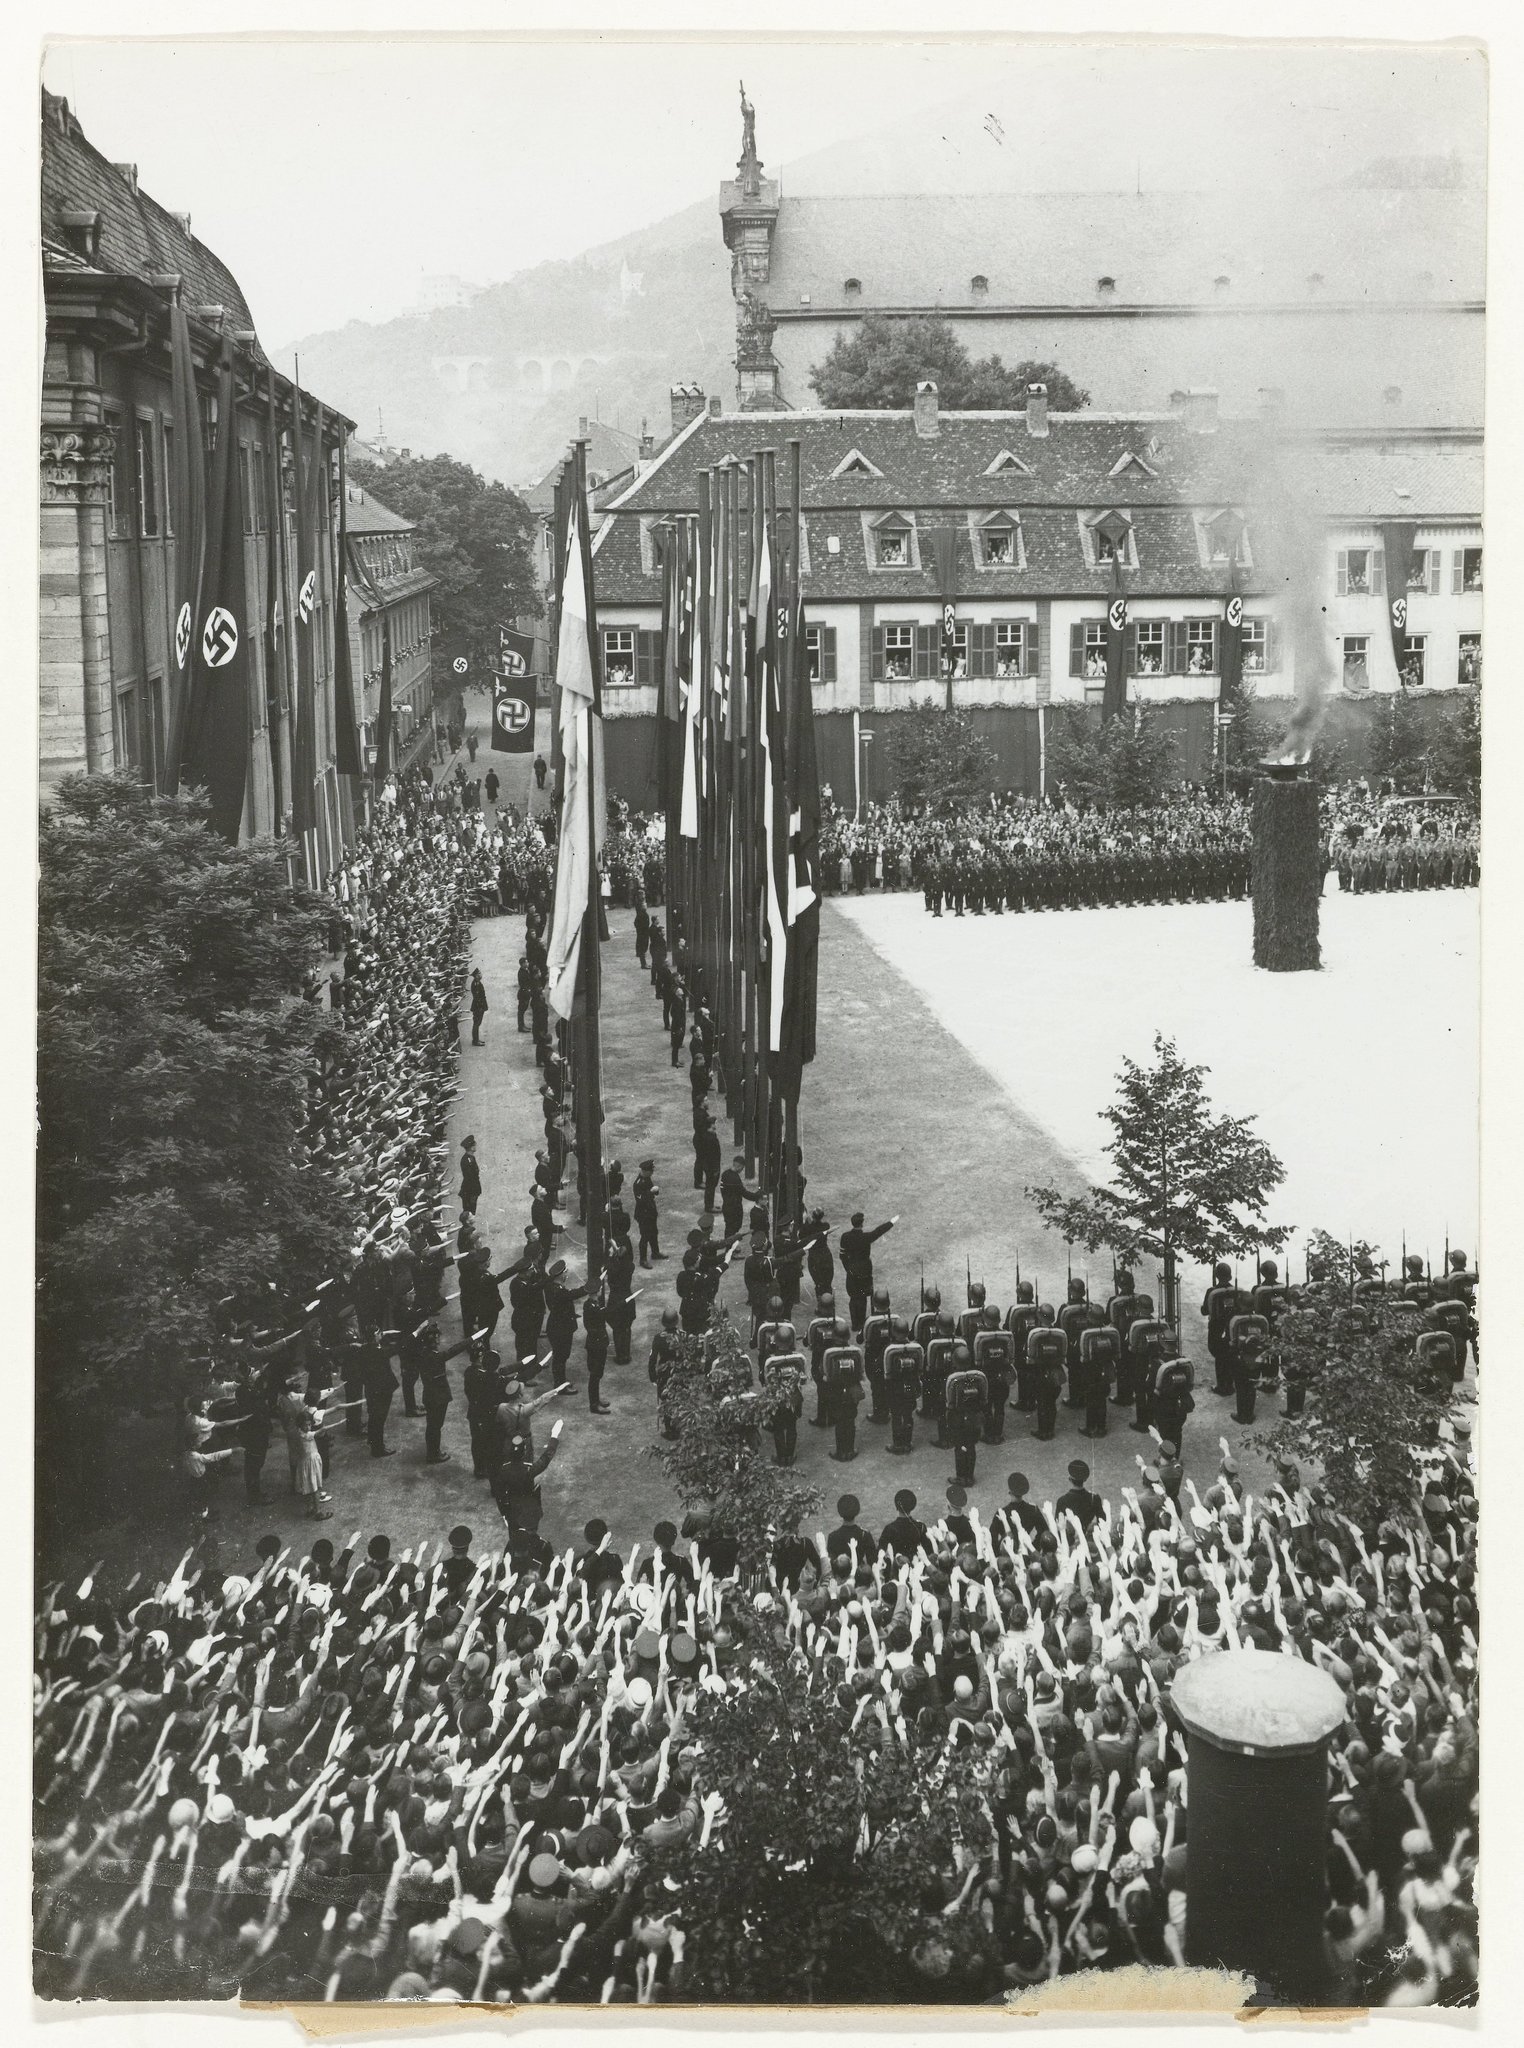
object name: photograph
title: 550-jarig bestaan Universiteit van Heidelberg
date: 1936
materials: photographic support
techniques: photography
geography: heidelberg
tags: universiteit van heidelberg, heidelberg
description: Viering van het 550-jarig bestaan van de Universiteit van Heidelberg. Uit 31 landen waren oud-studenten naar Heidelberg gekomen. Ze brengen de Hitler groet aan de vlaggen uit de 31 landen op de binnenplaats van de Universiteit